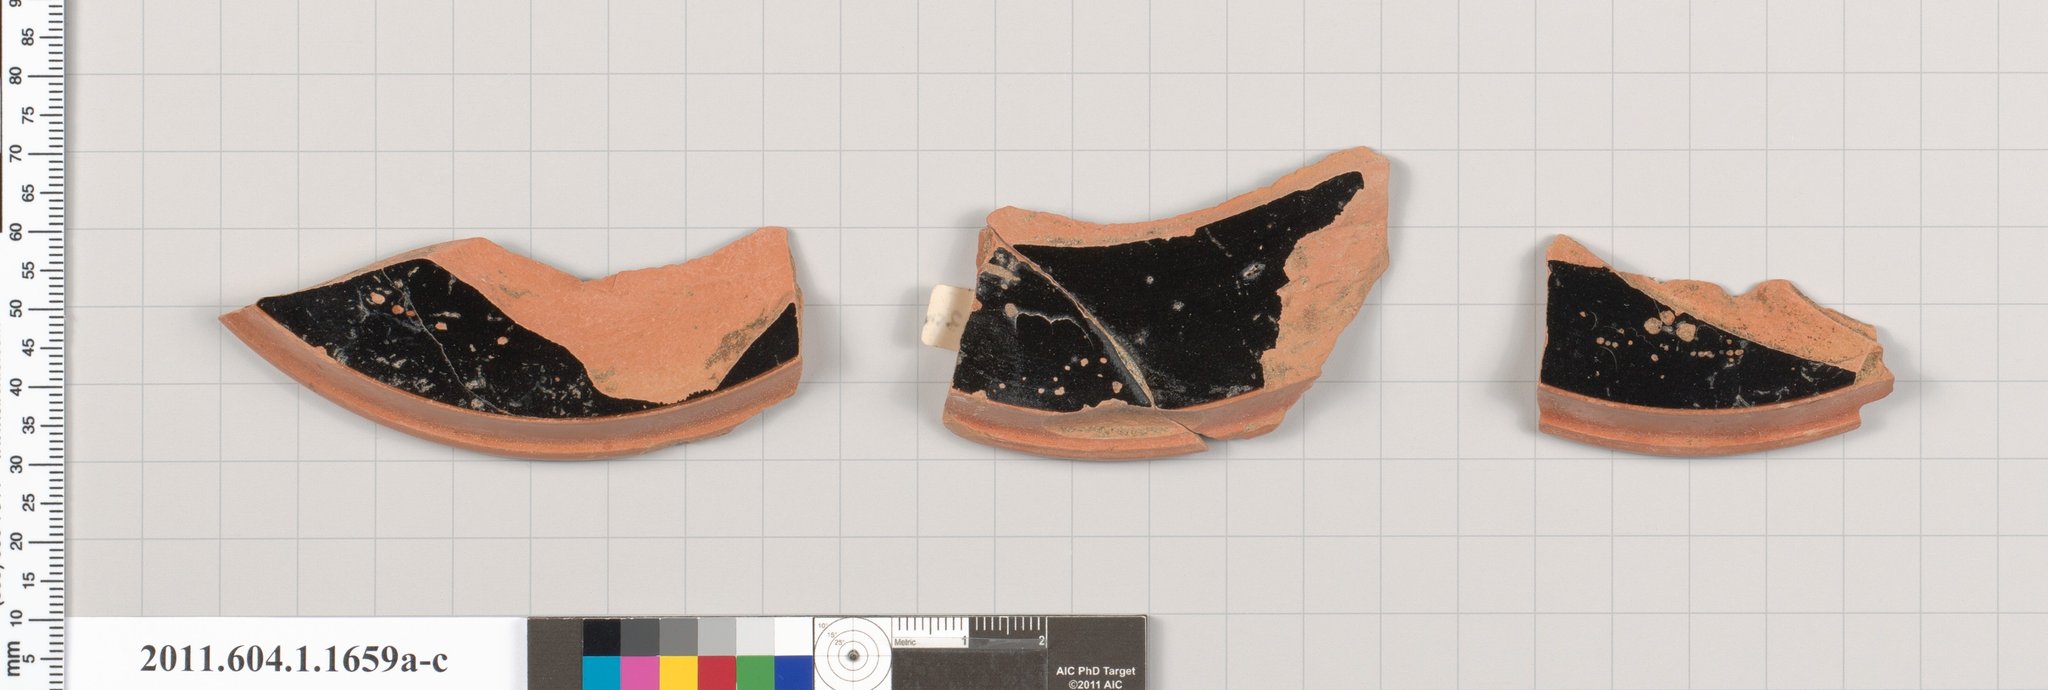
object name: kylix fragment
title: Terracotta fragments of a kylix (drinking cup)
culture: greek, attic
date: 530-510 BCE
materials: terracotta